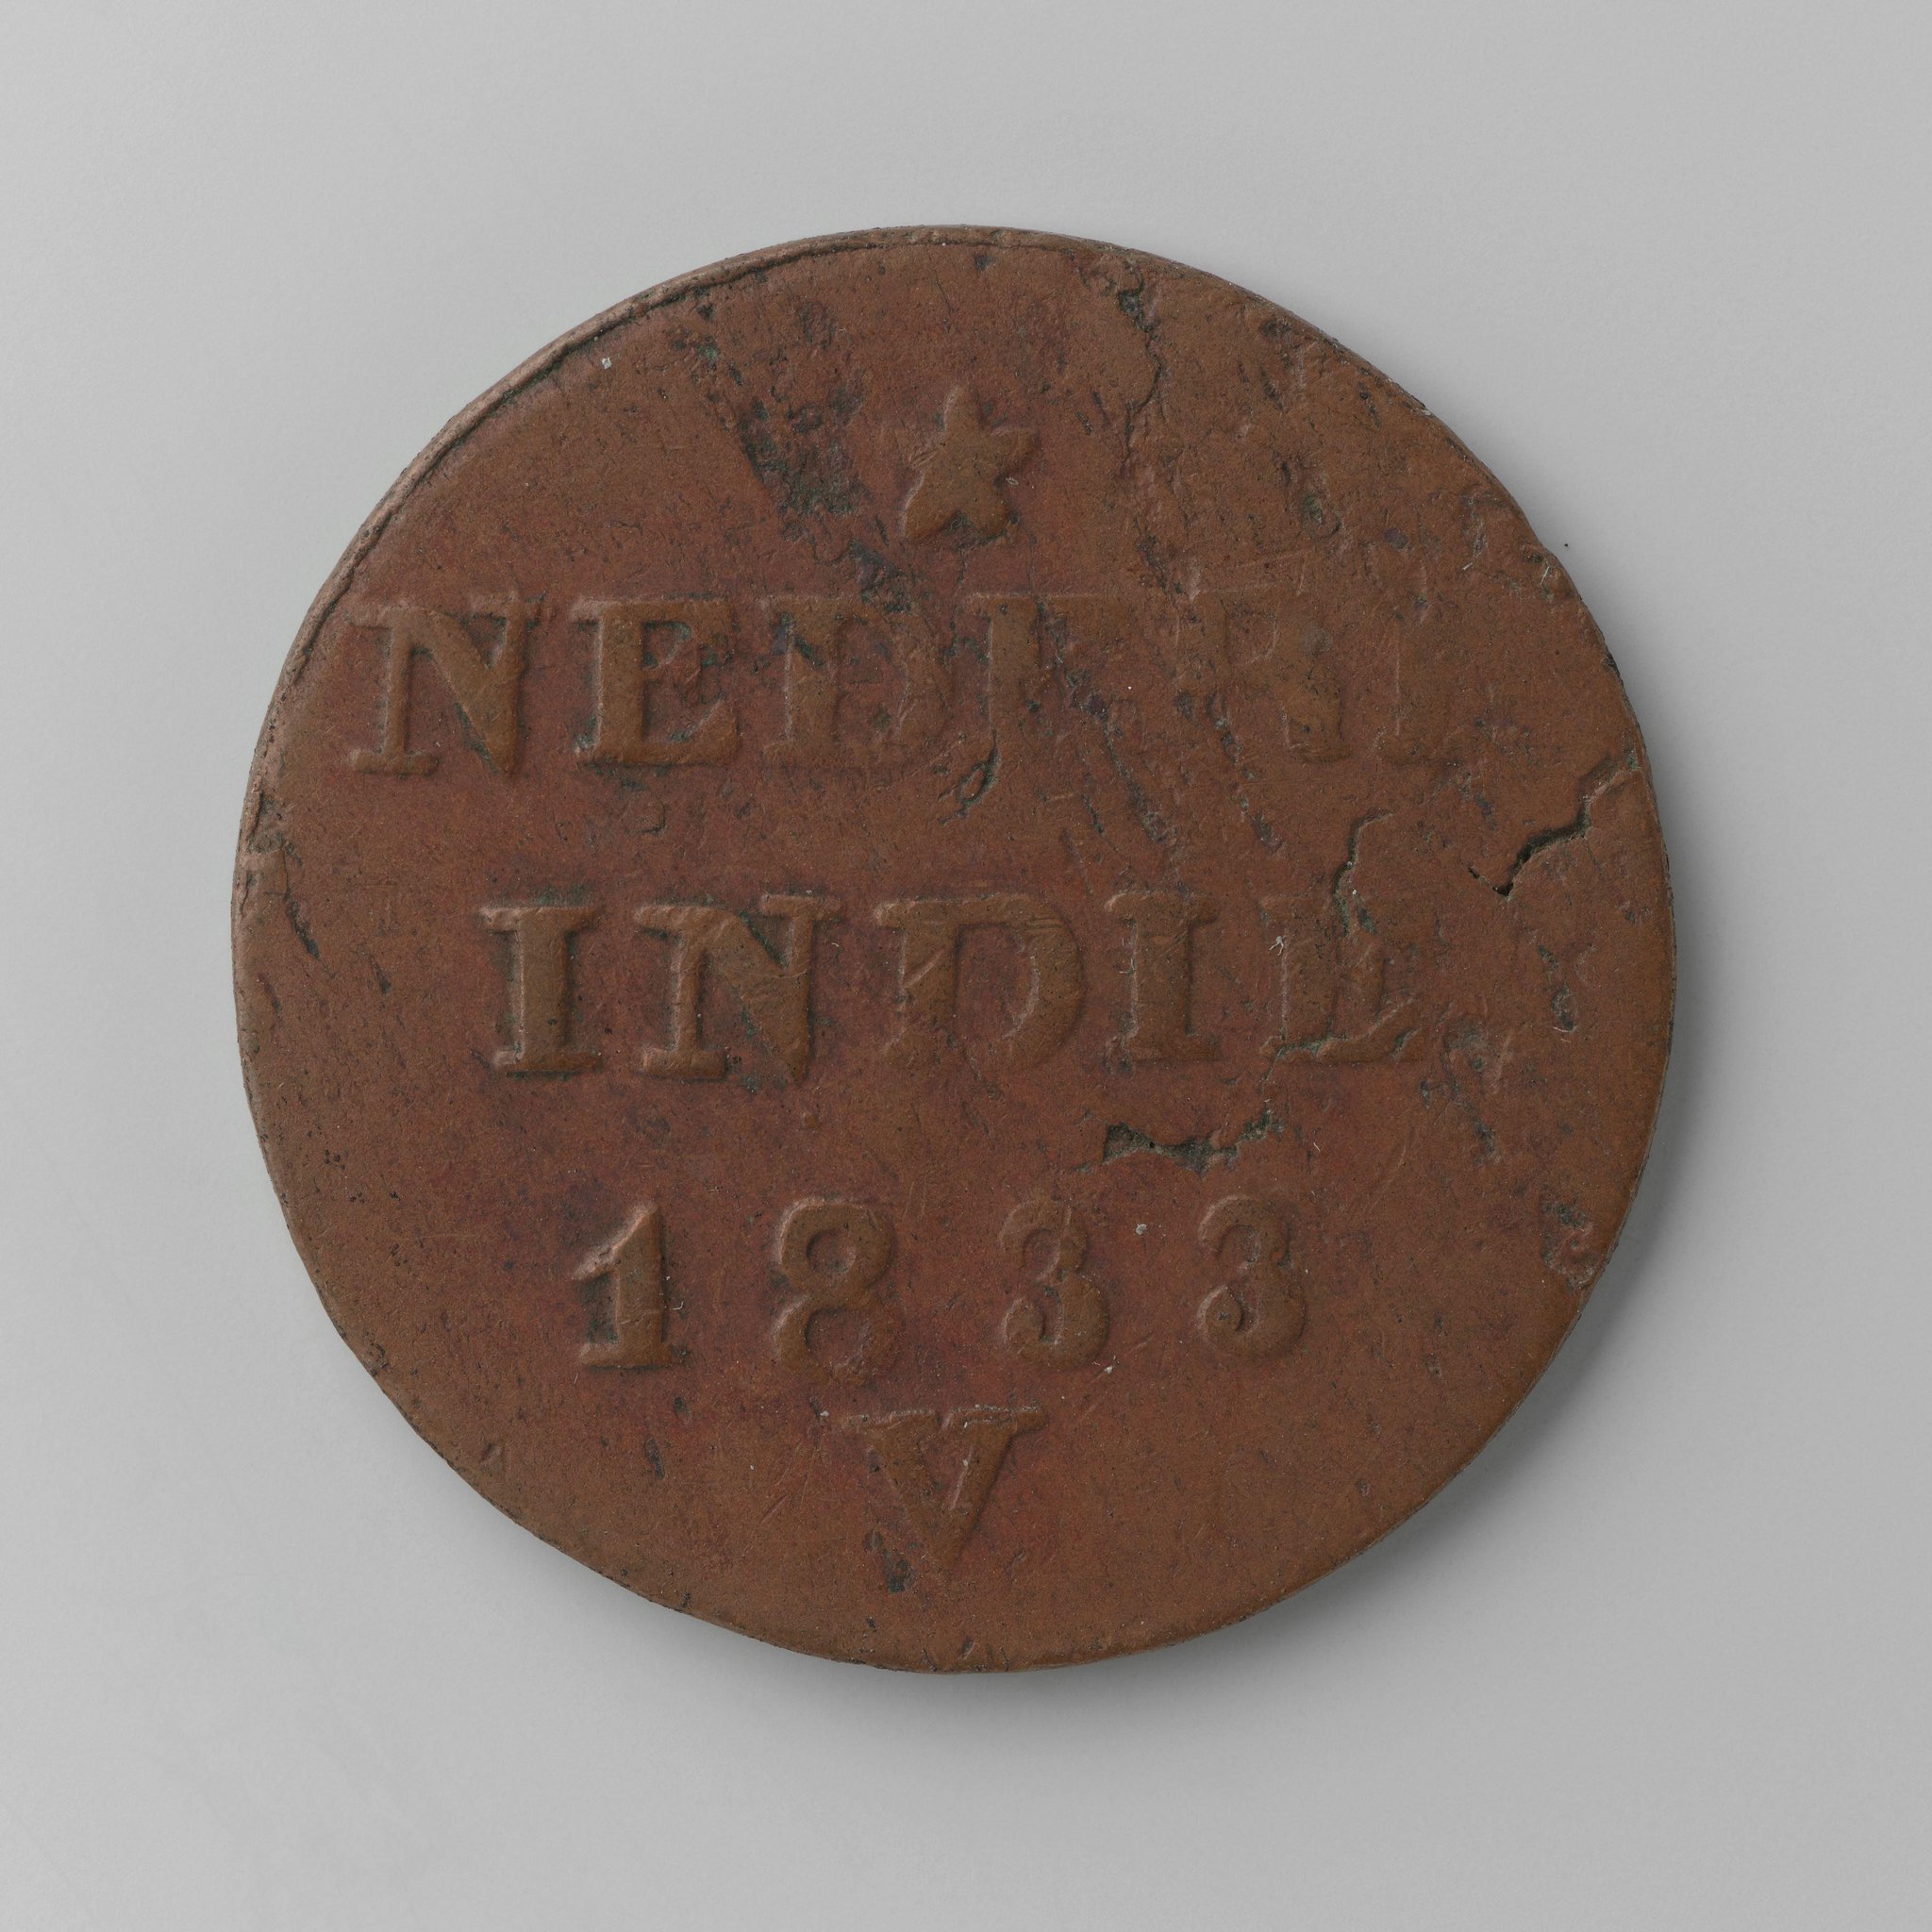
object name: coin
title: 2 cent van Nederlands Indië,1833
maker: william i of the netherlands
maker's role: koning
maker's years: 1772-1843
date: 1833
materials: copper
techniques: striking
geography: surabaya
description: Koperen munt. Voorzijde: tussen waarde-aanduiding 2 CT. gekroond rijkswapenschild. Keerzijde: tweeregelig opschrift, waarboven muntteken en waaronder jaartal. Daaronder letter V [=muntmeester De Vogel]. Gladde rand.